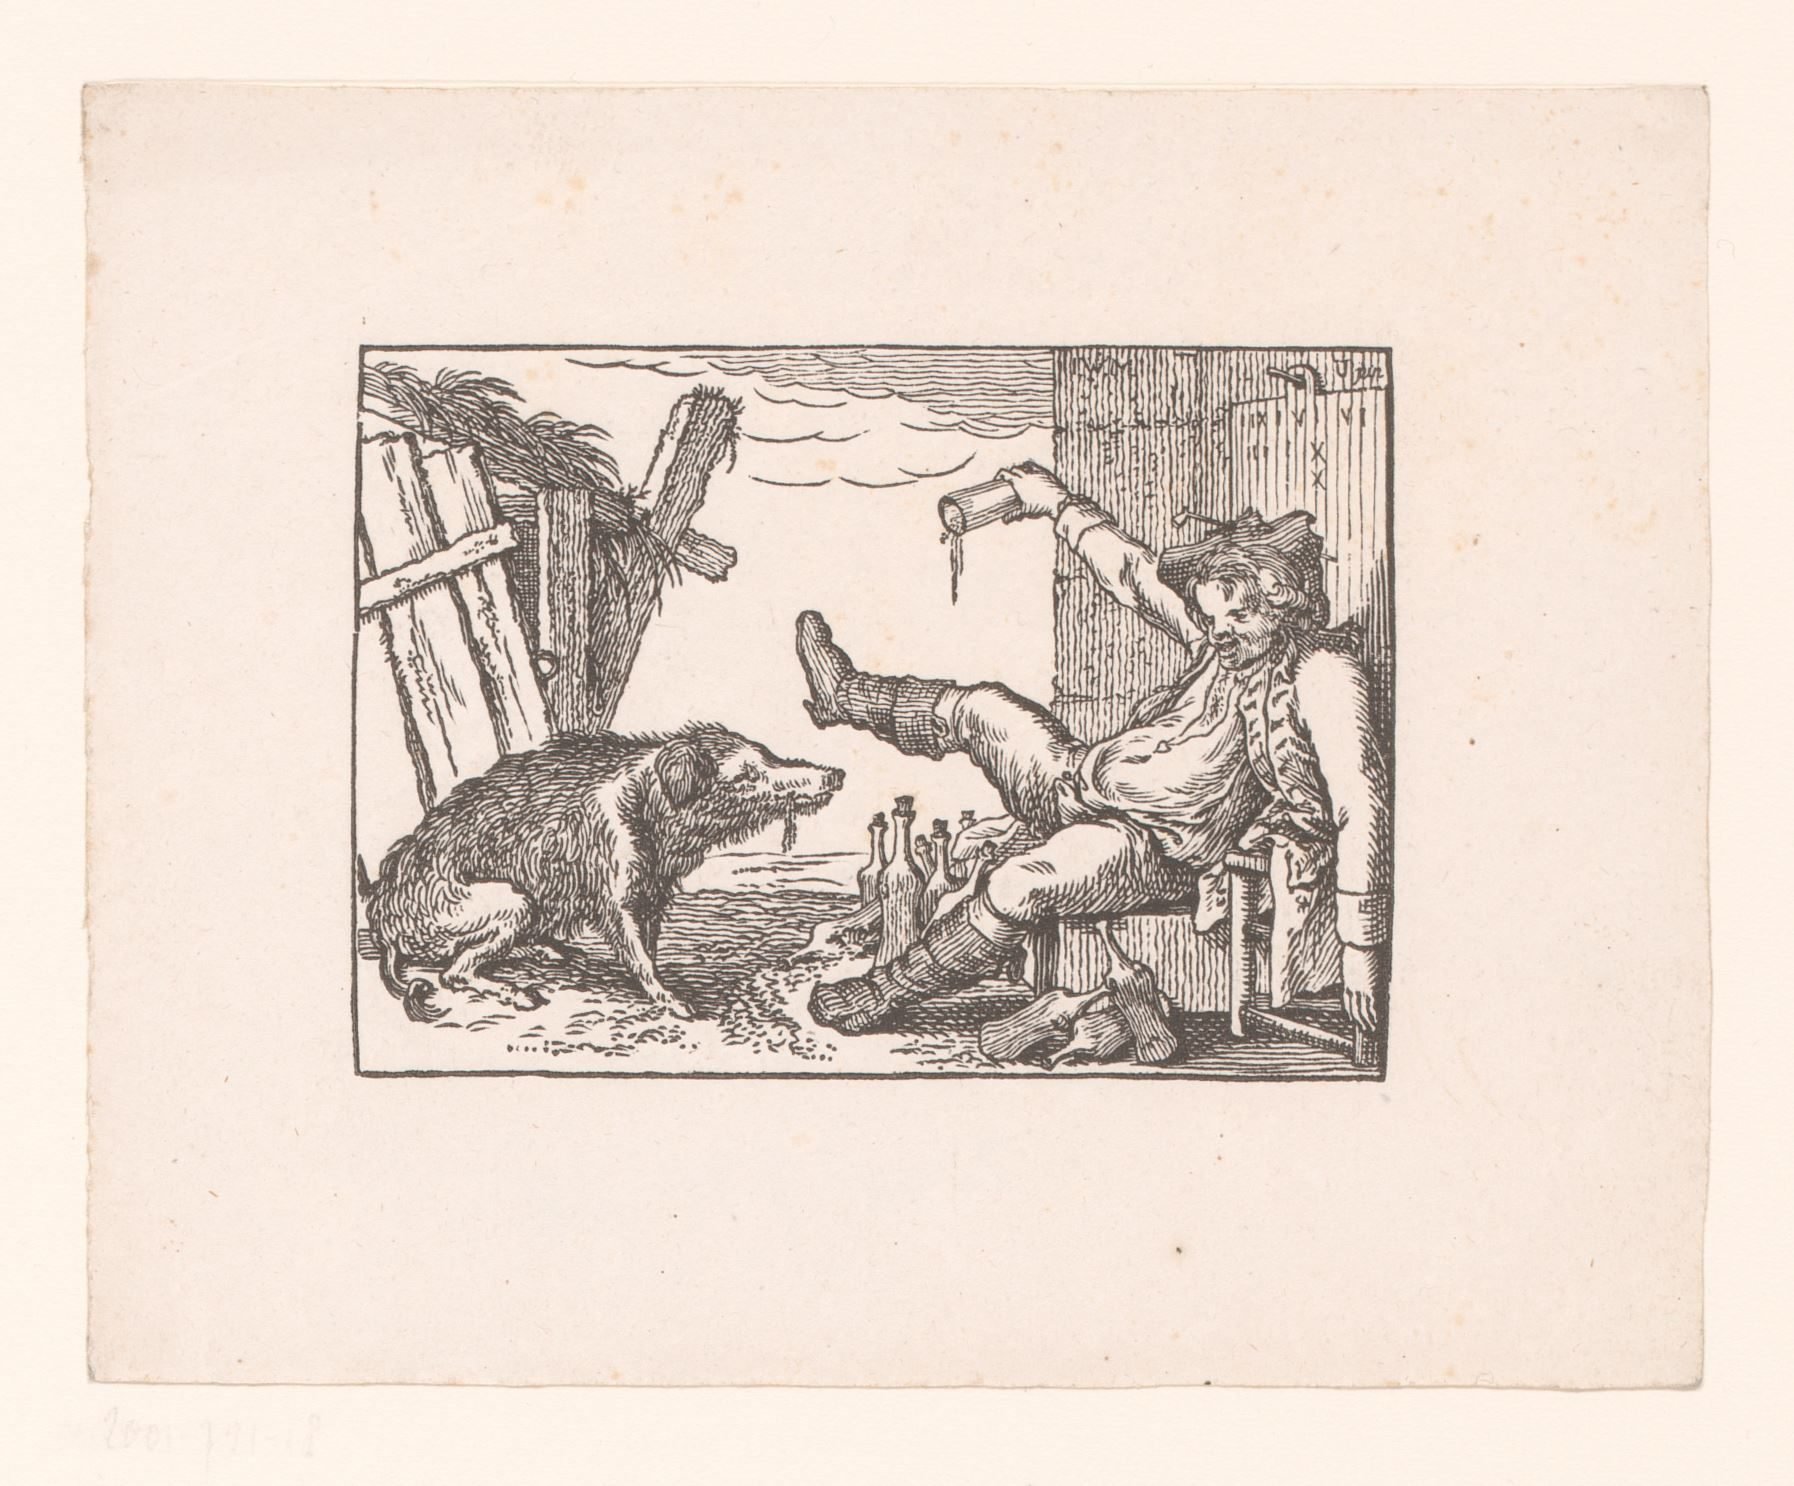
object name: print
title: Dronkaard en zwijn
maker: johann friedrich gottlieb unger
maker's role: print maker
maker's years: 1753-1804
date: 1763-1804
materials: paper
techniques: woodcut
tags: pig, drunkard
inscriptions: collector's mark: Lugt 2228